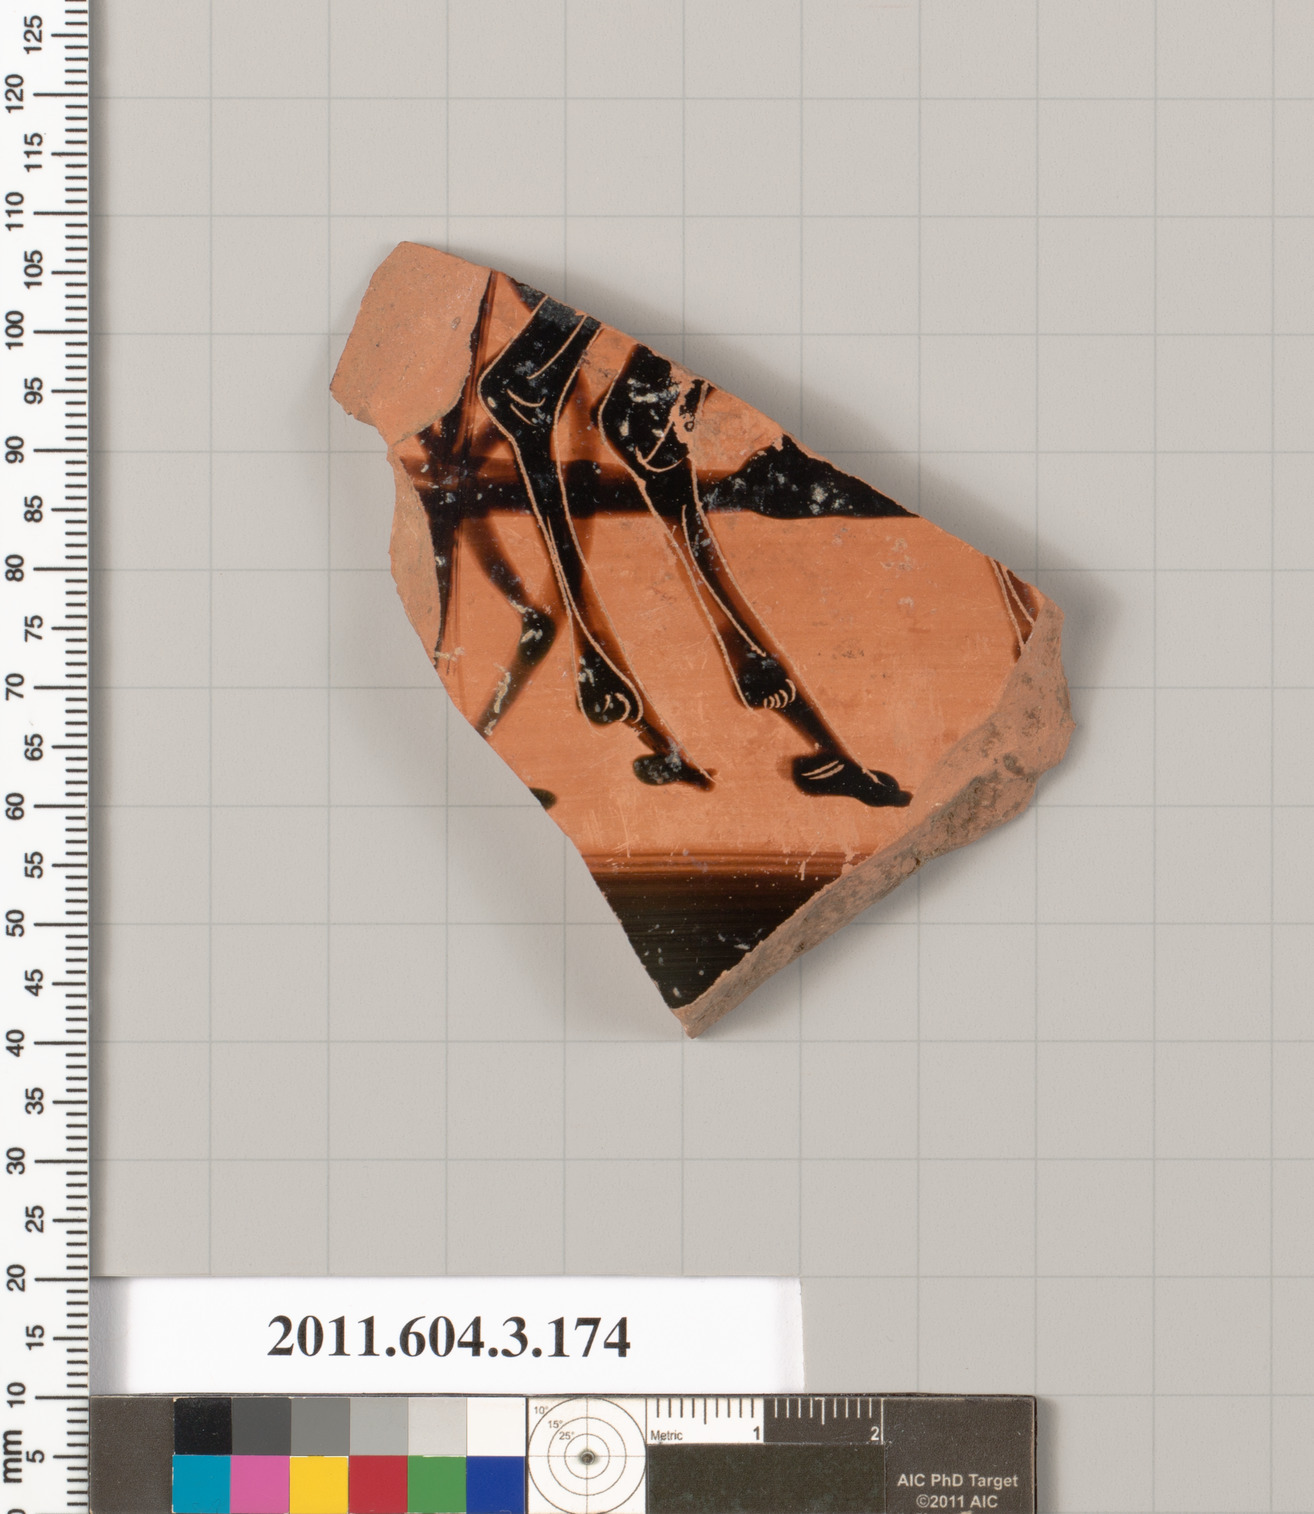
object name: amphora fragment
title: Terracotta fragment of an amphora (jar)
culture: greek, attic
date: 525-501 BCE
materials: terracotta